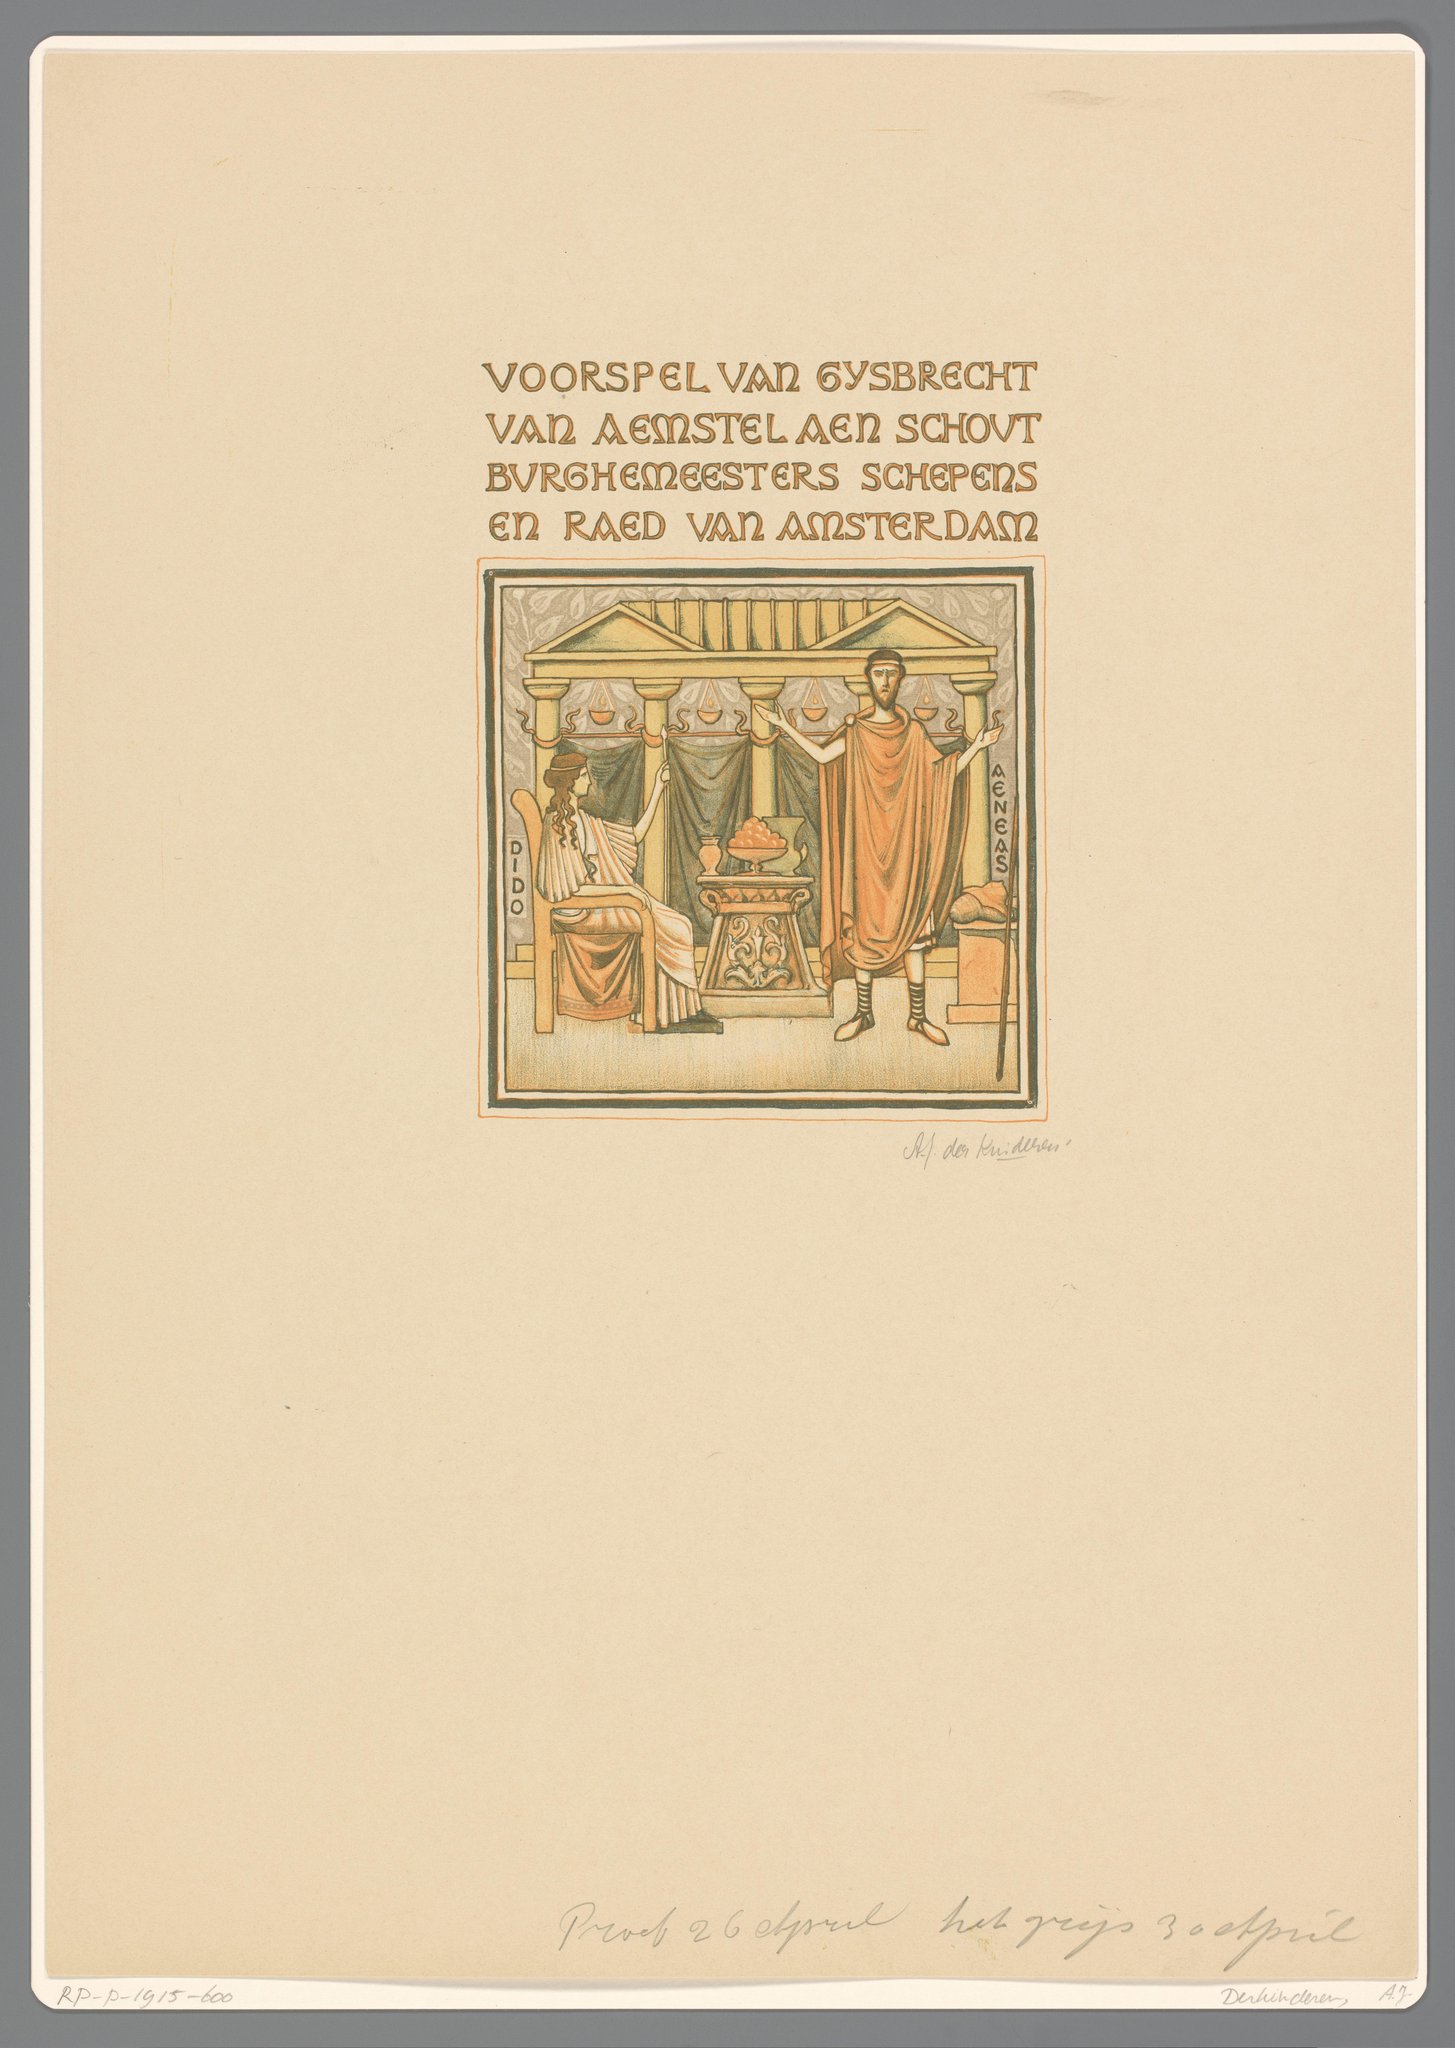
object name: book illustration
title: Dido en Aeneas in een interieur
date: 1894-1901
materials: paper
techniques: lithograph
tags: (story of) dido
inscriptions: collector's mark: Lugt 2233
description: Prent gebruikt voor: Vondel, Joost van den. Gysbreght van Aemstel. Haarlem: Erven F. Bohn, 1894-1901. De voorstelling is door Tresling & Comp. op steen overgebracht.